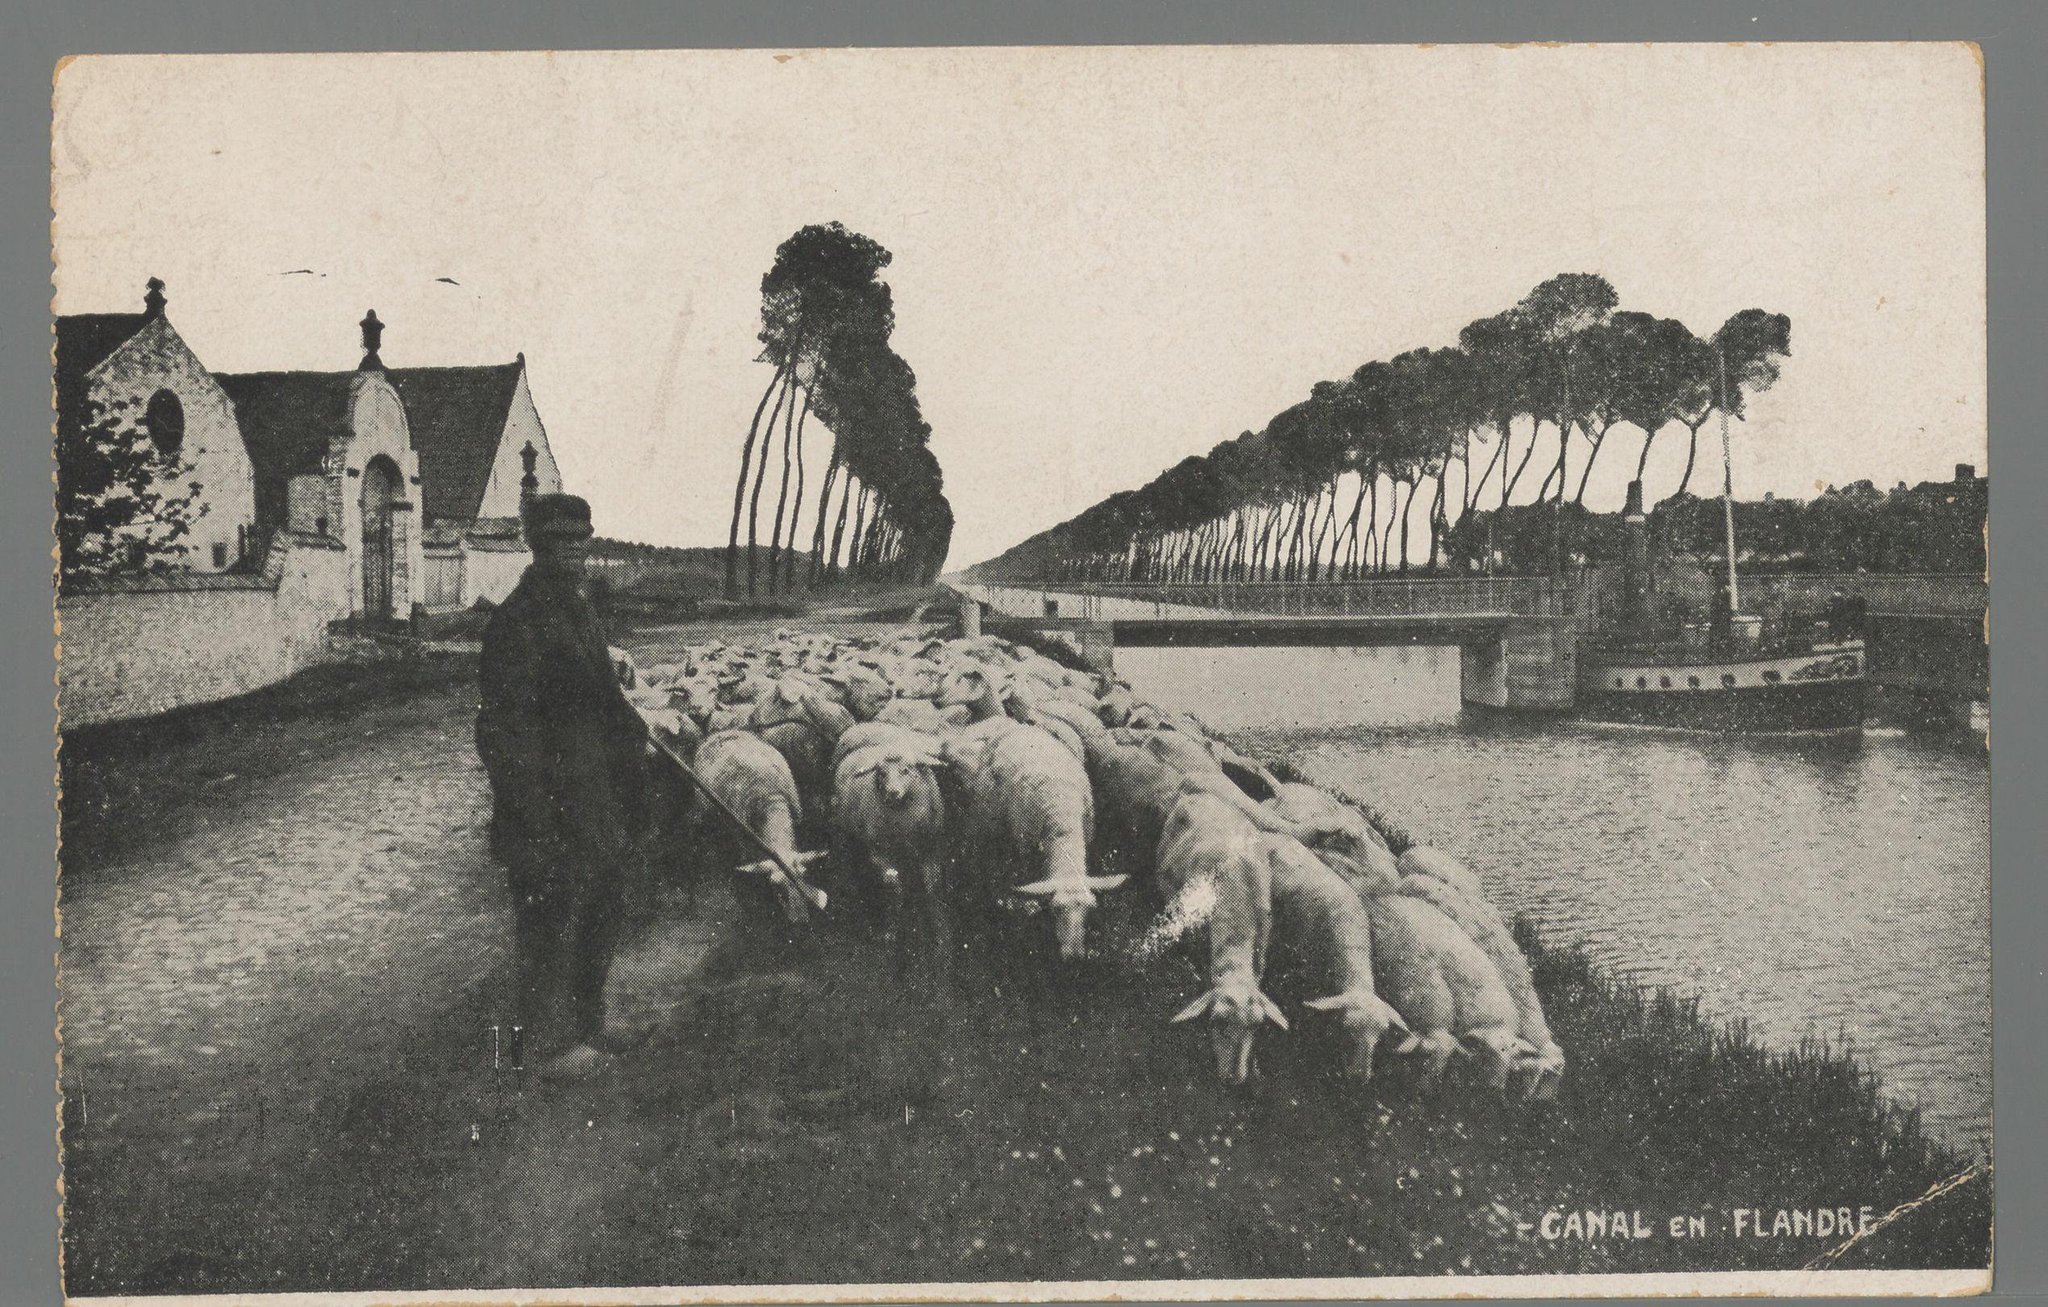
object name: photomechanical print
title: Canal en Flandre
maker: Anonymous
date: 1906-1930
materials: cardboard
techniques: autotype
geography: flanders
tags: canal, cattle driving, cattle driver, sheep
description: Herder met schapen aan een vaart, mogelijk bij Damme.